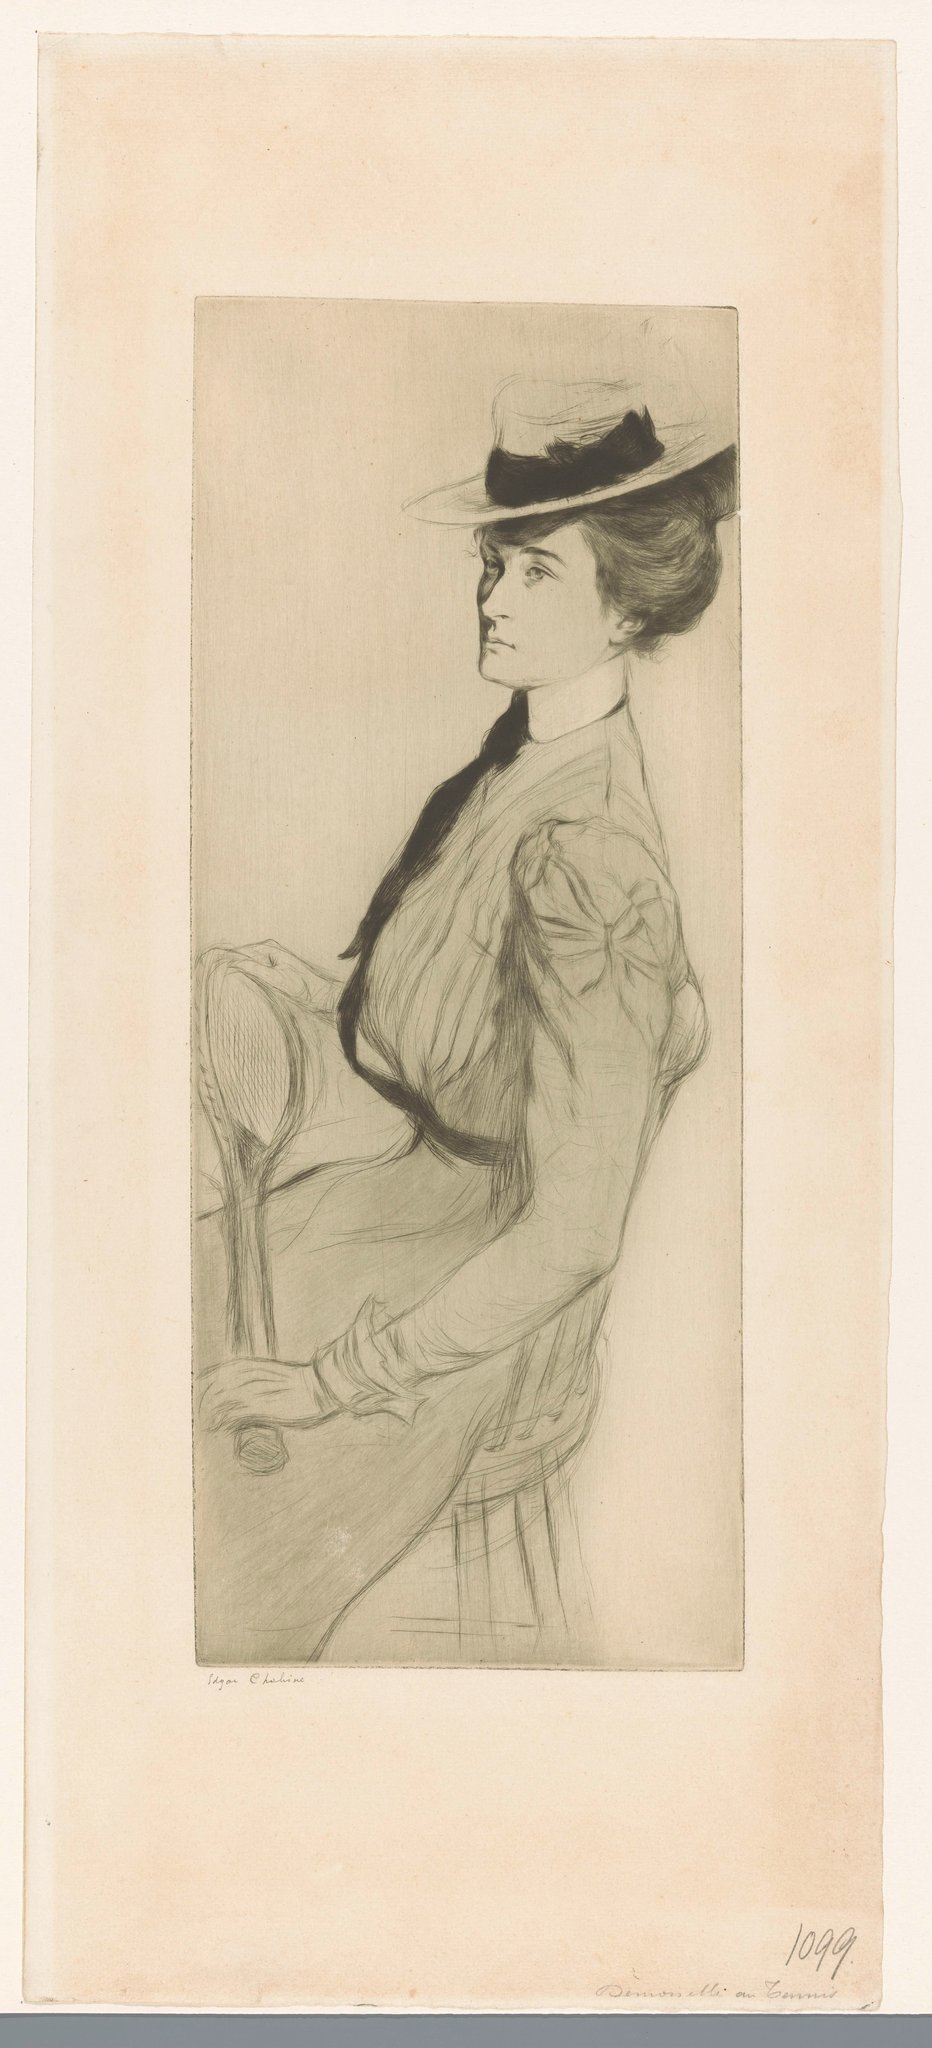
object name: print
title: Zittende vrouw met een tennisracket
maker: edgar chahine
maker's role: print maker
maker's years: 1874-1947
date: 1899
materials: paper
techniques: drypoint, intaglio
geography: france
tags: tennis, lawn-tennis, adult woman, head-gear: hat